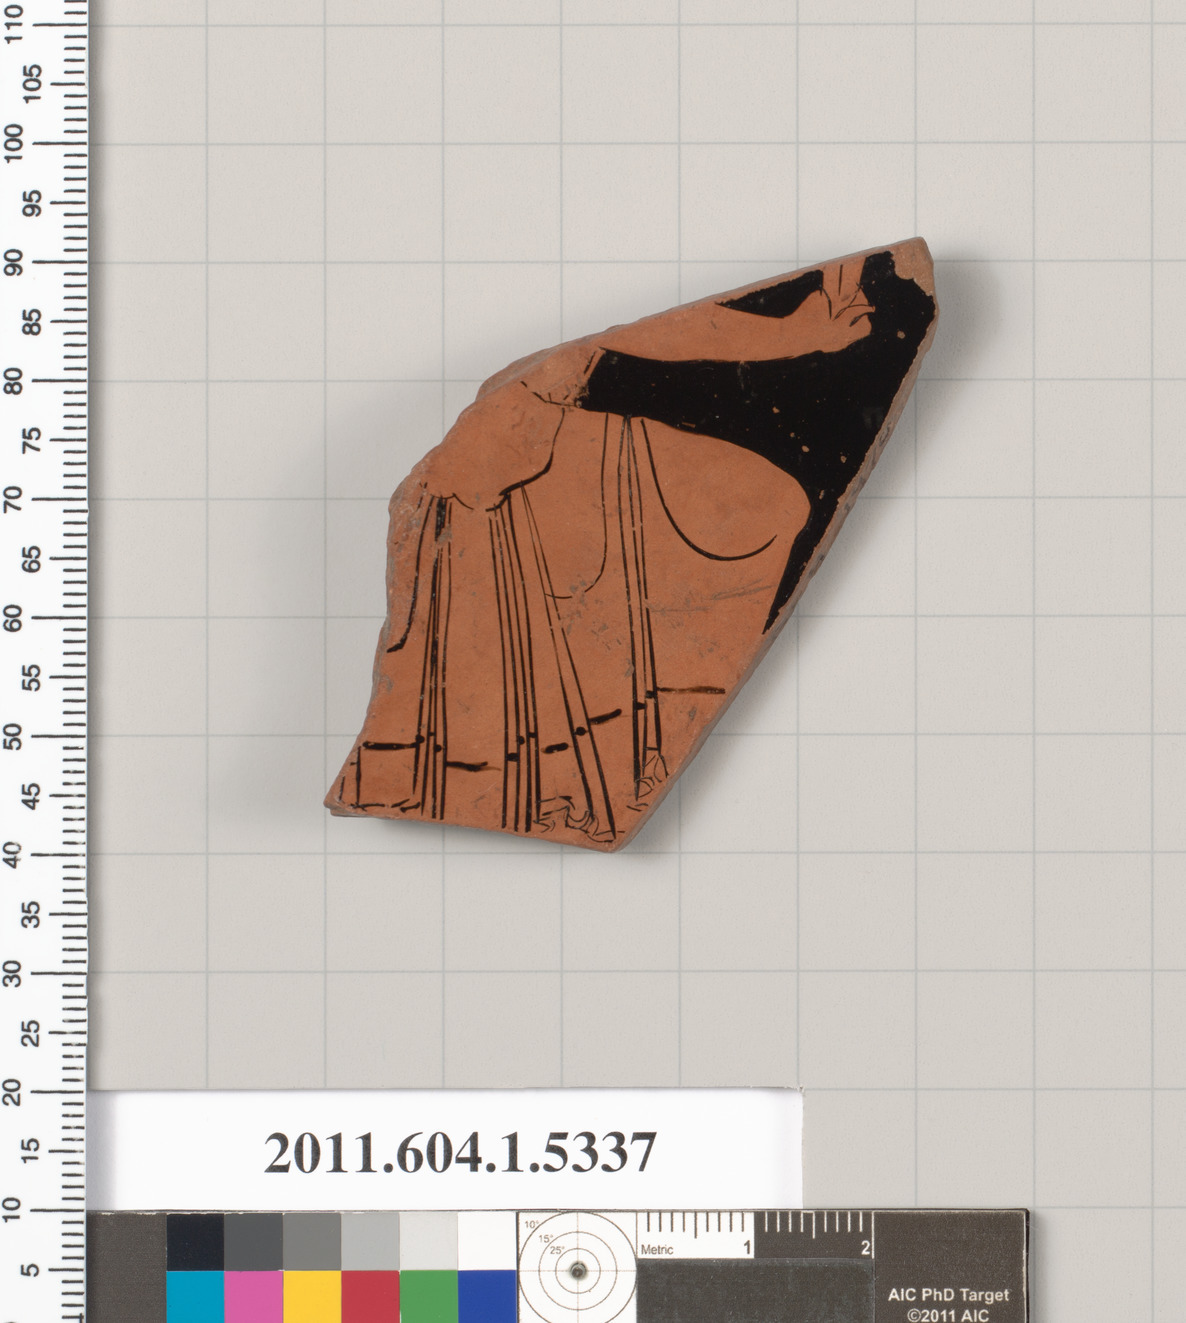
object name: kylix fragment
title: Terracotta fragment of a kylix (drinking cup)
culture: greek, attic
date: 490-470 BCE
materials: terracotta